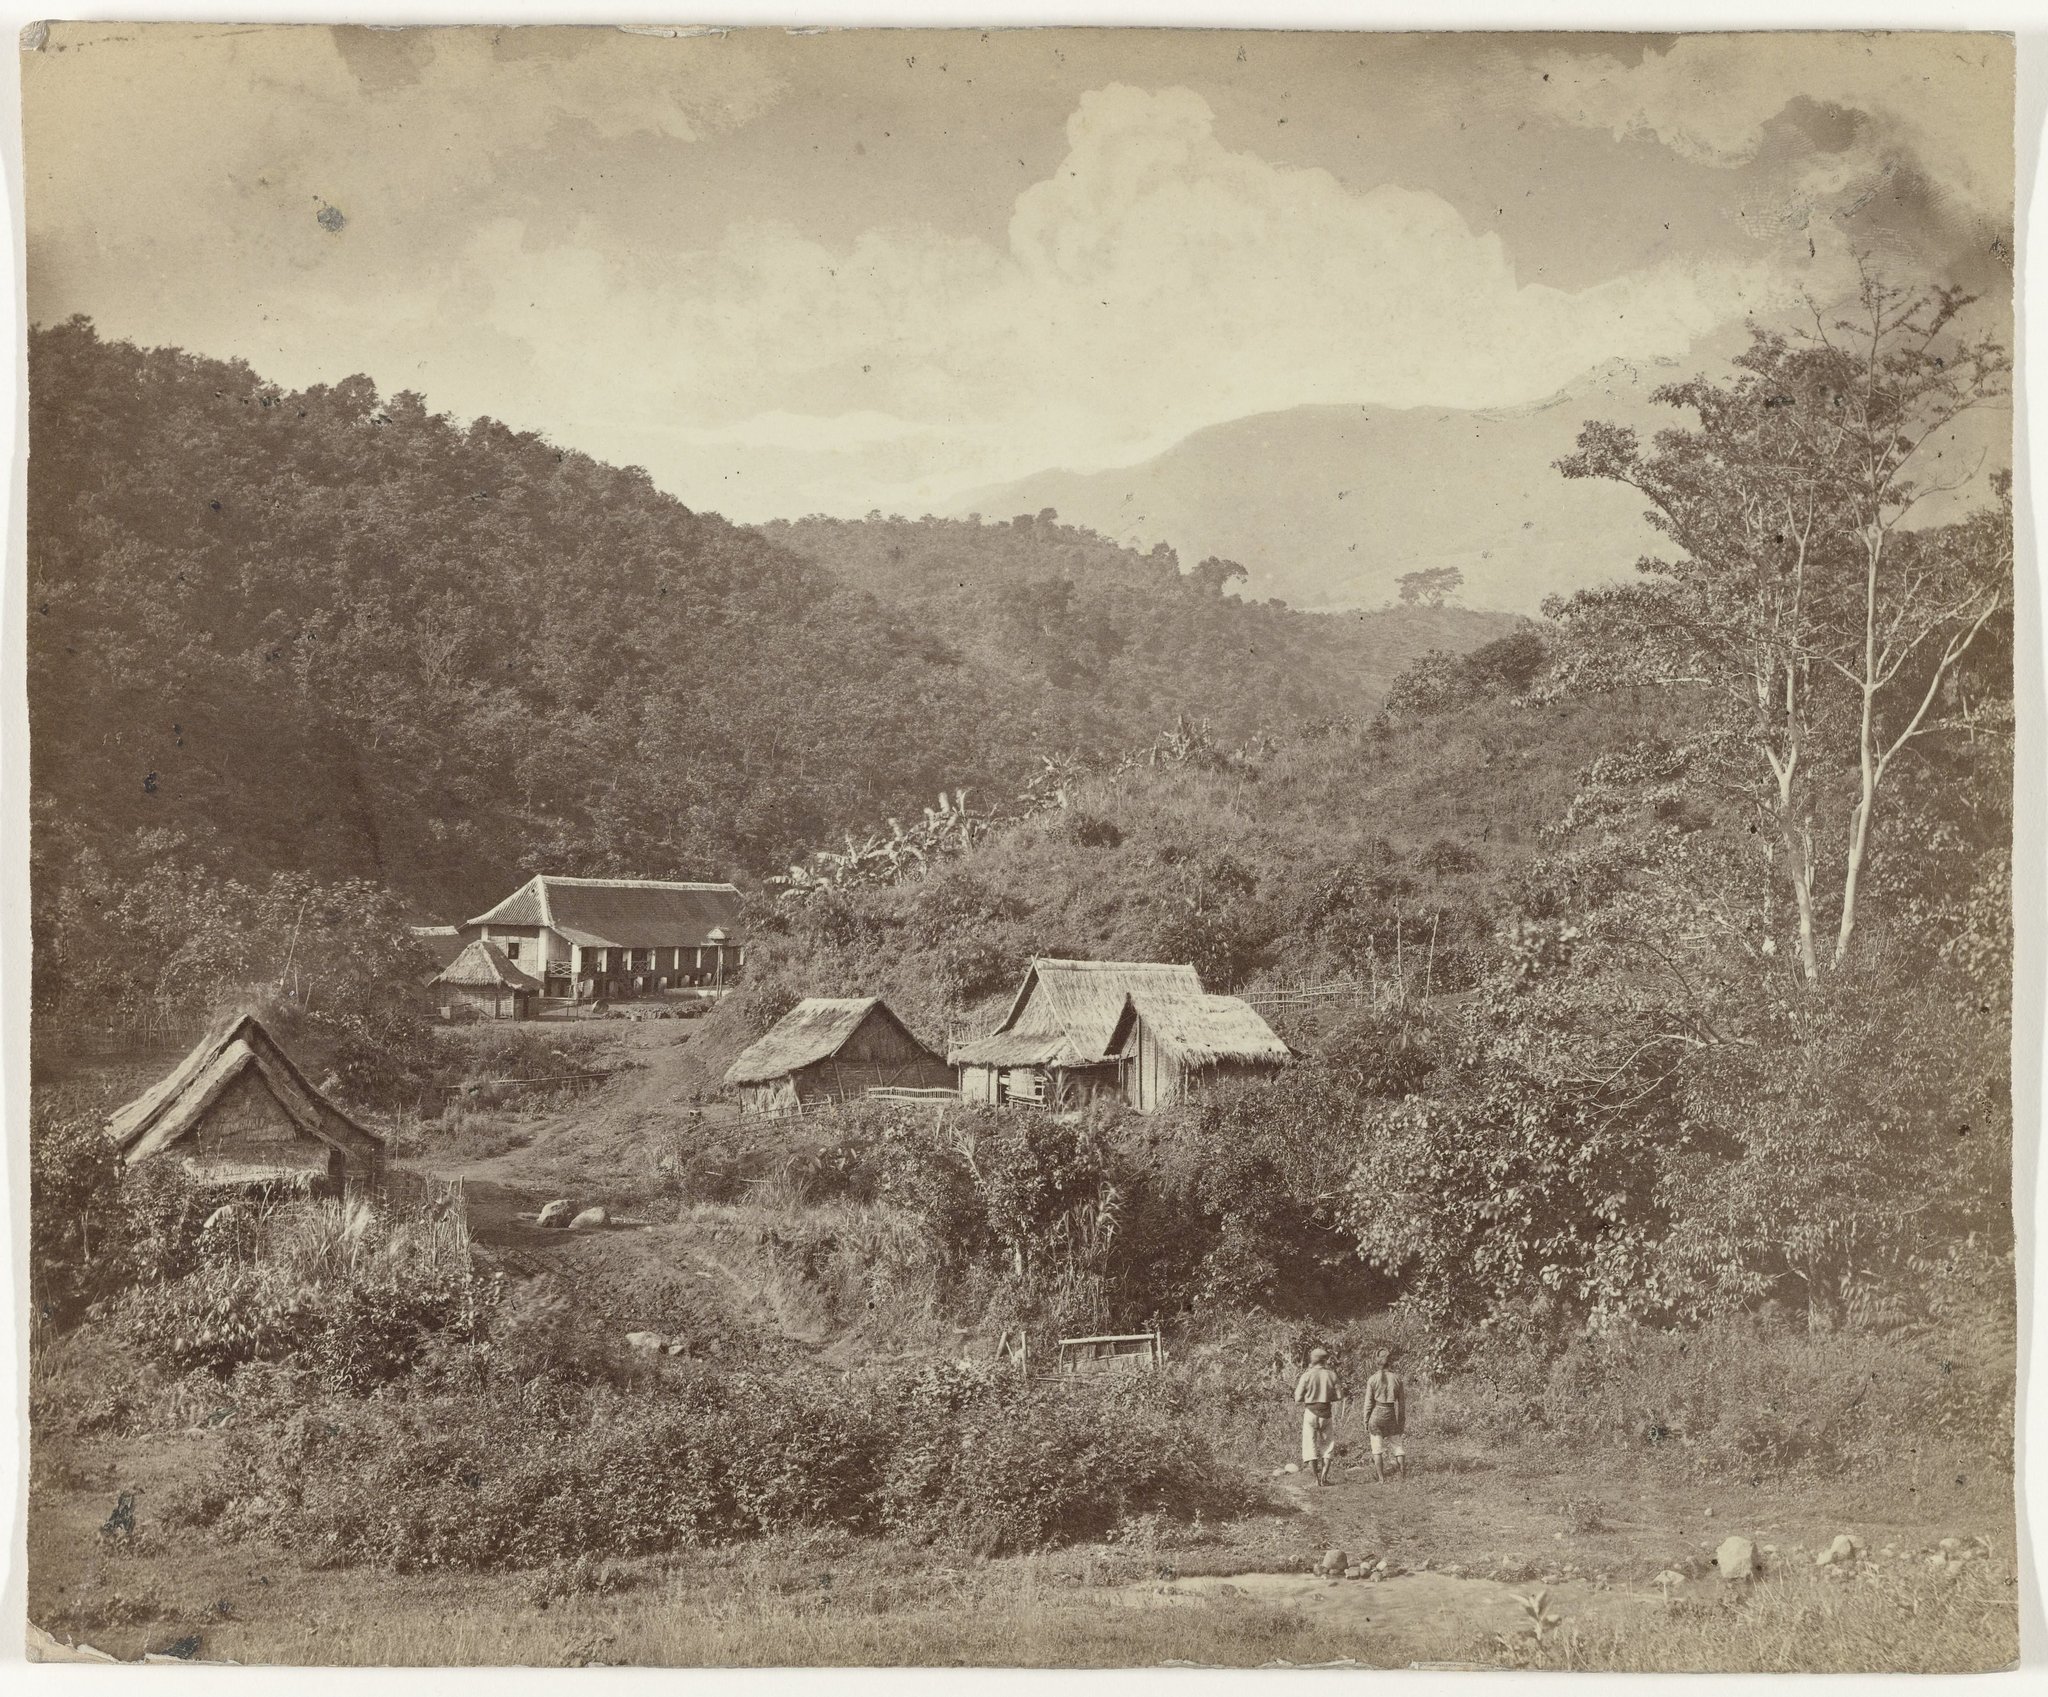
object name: photograph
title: Kawigebergte 8820 vt (Hoogste top Boedah / Telekoong bij Batoe / Koffe land Grens Panawanang / Malang Kedirie)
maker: Anonymous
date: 1880-1888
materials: photographic support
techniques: albumen print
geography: malang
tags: malang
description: Hutten van een dorp in het Kawigebergte op 8820 voet te Malang. Onderdeel van een groep van 62 foto's in een doos met het opschrift "Staatsspoorwegen op Java" uit 1888.